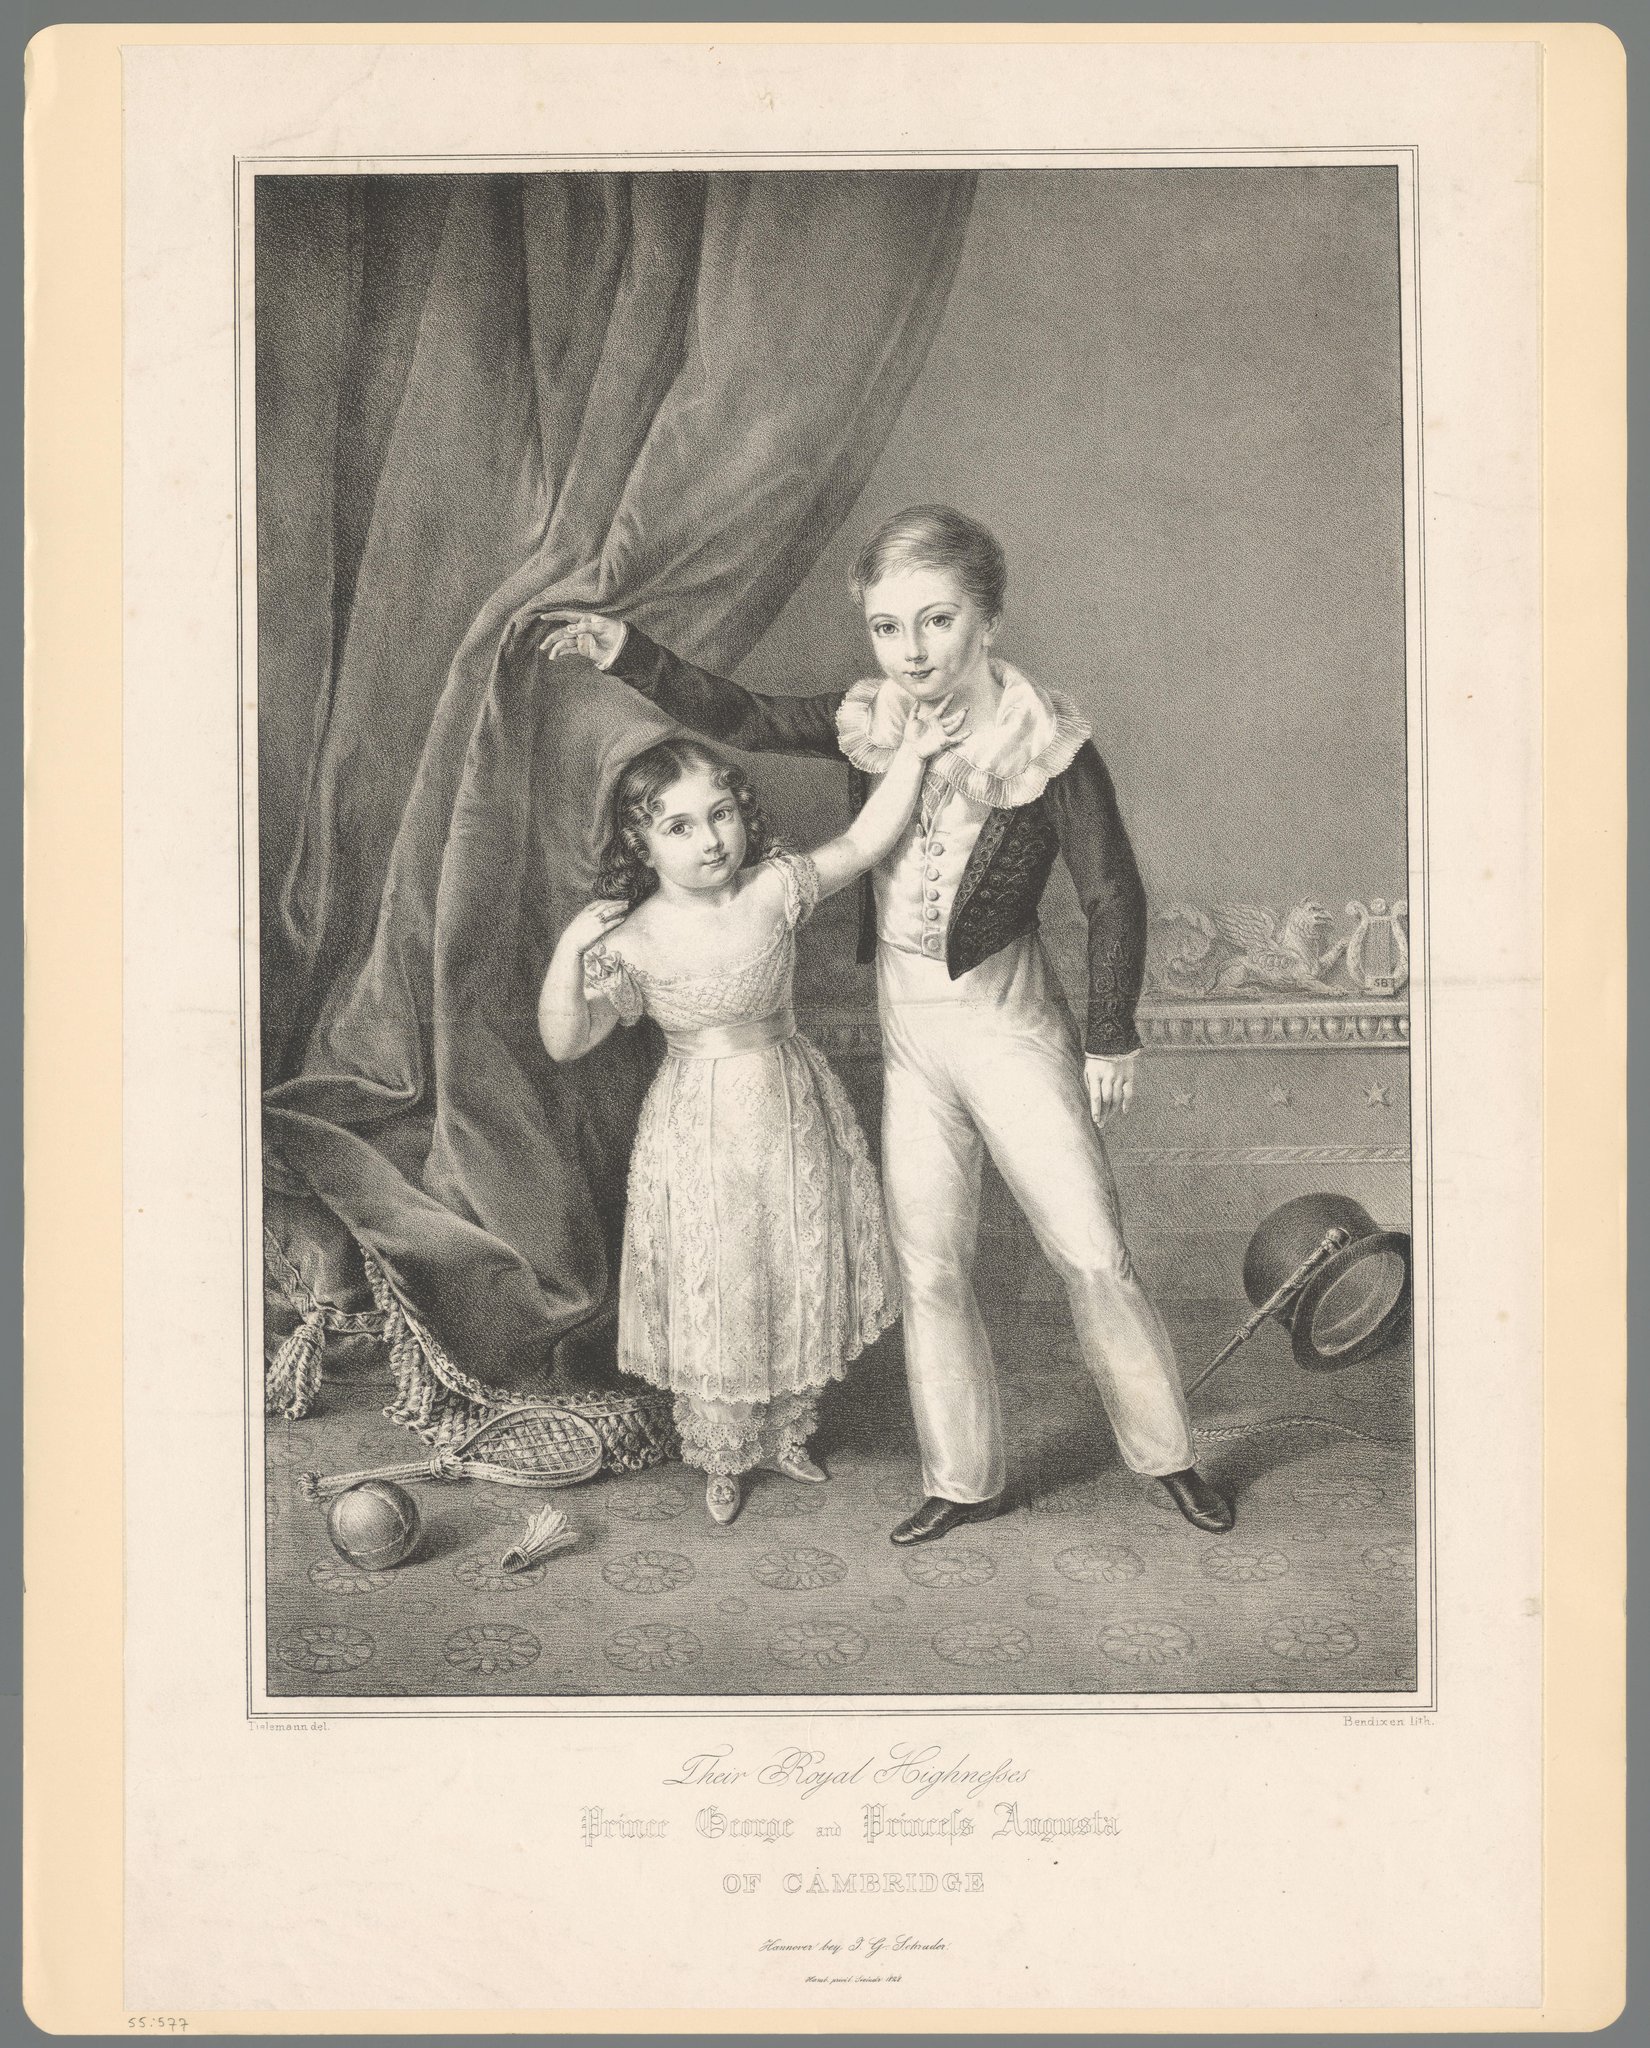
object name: print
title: Their Royal Highnesses prince George and princess Augusta of Cambridge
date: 1828-1864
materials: paper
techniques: lithograph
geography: hannover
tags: london, curtains, child, historical persons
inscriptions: collector's mark: Lugt 2228, check stamp